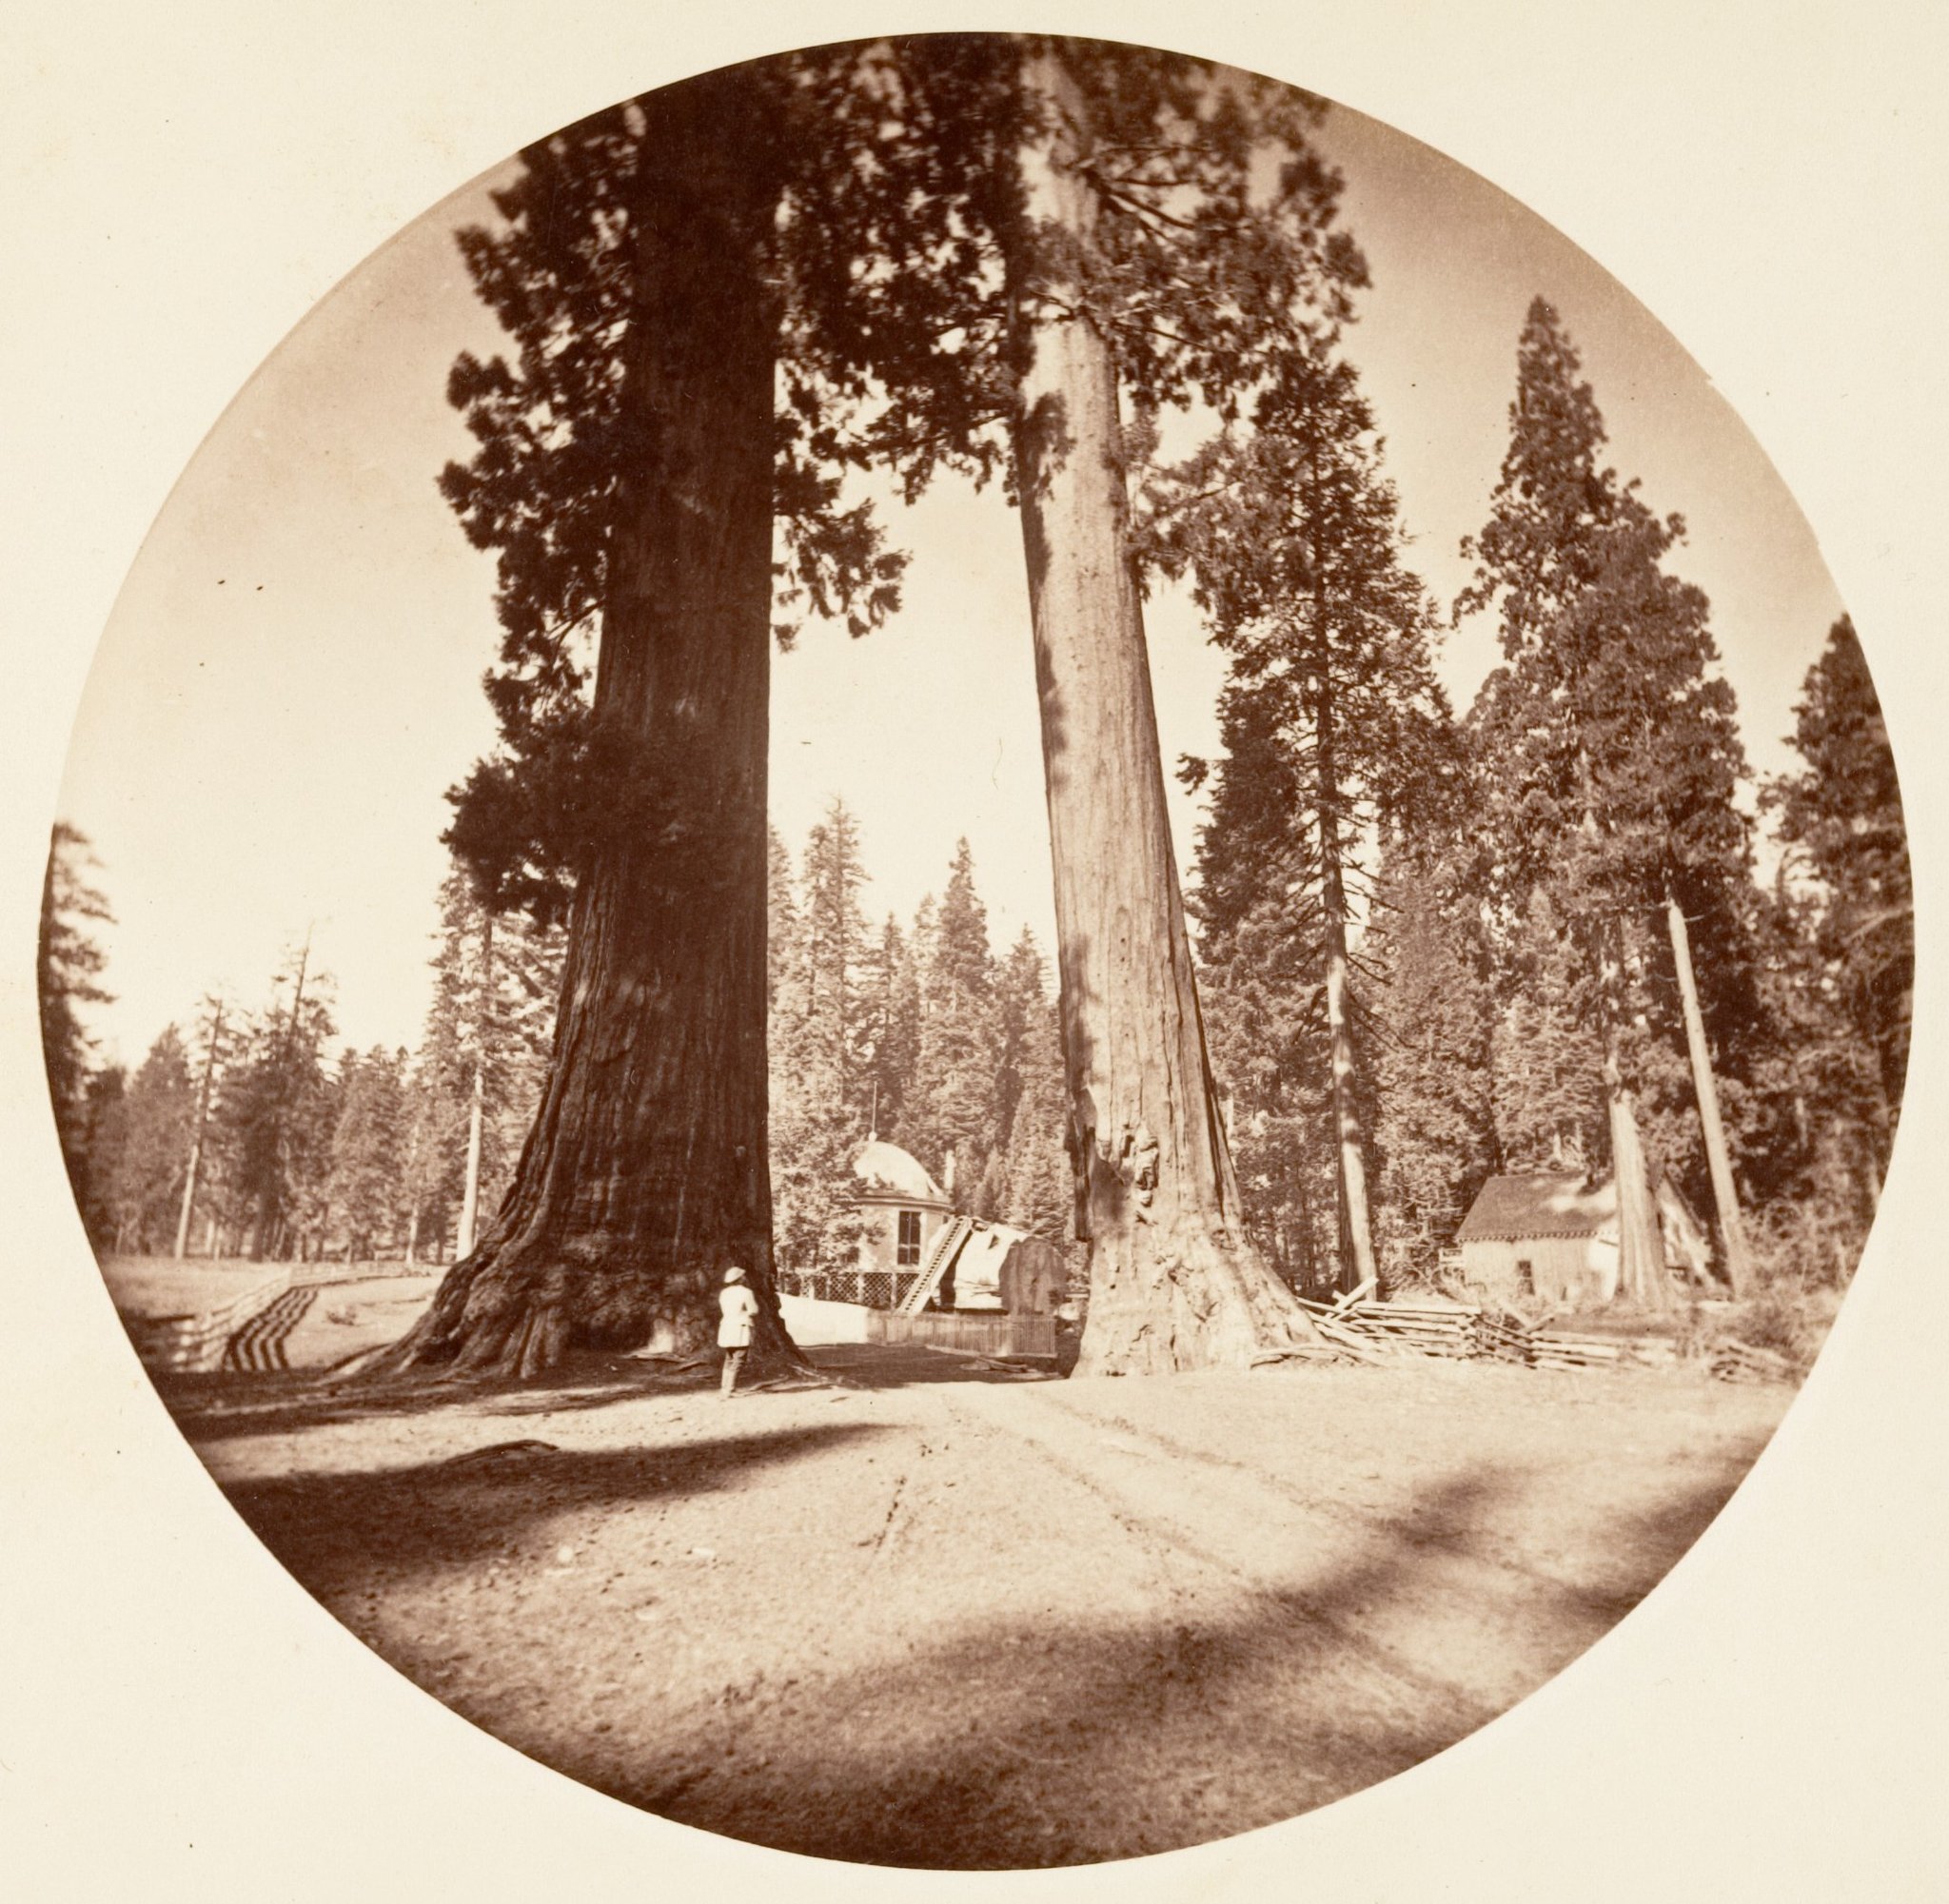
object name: photograph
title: The Sentinels - Calaveras Grove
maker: carleton e. watkins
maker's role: artist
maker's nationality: american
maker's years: 1829-1916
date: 1878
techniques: albumen silver print, glass negative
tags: landscapes,trees